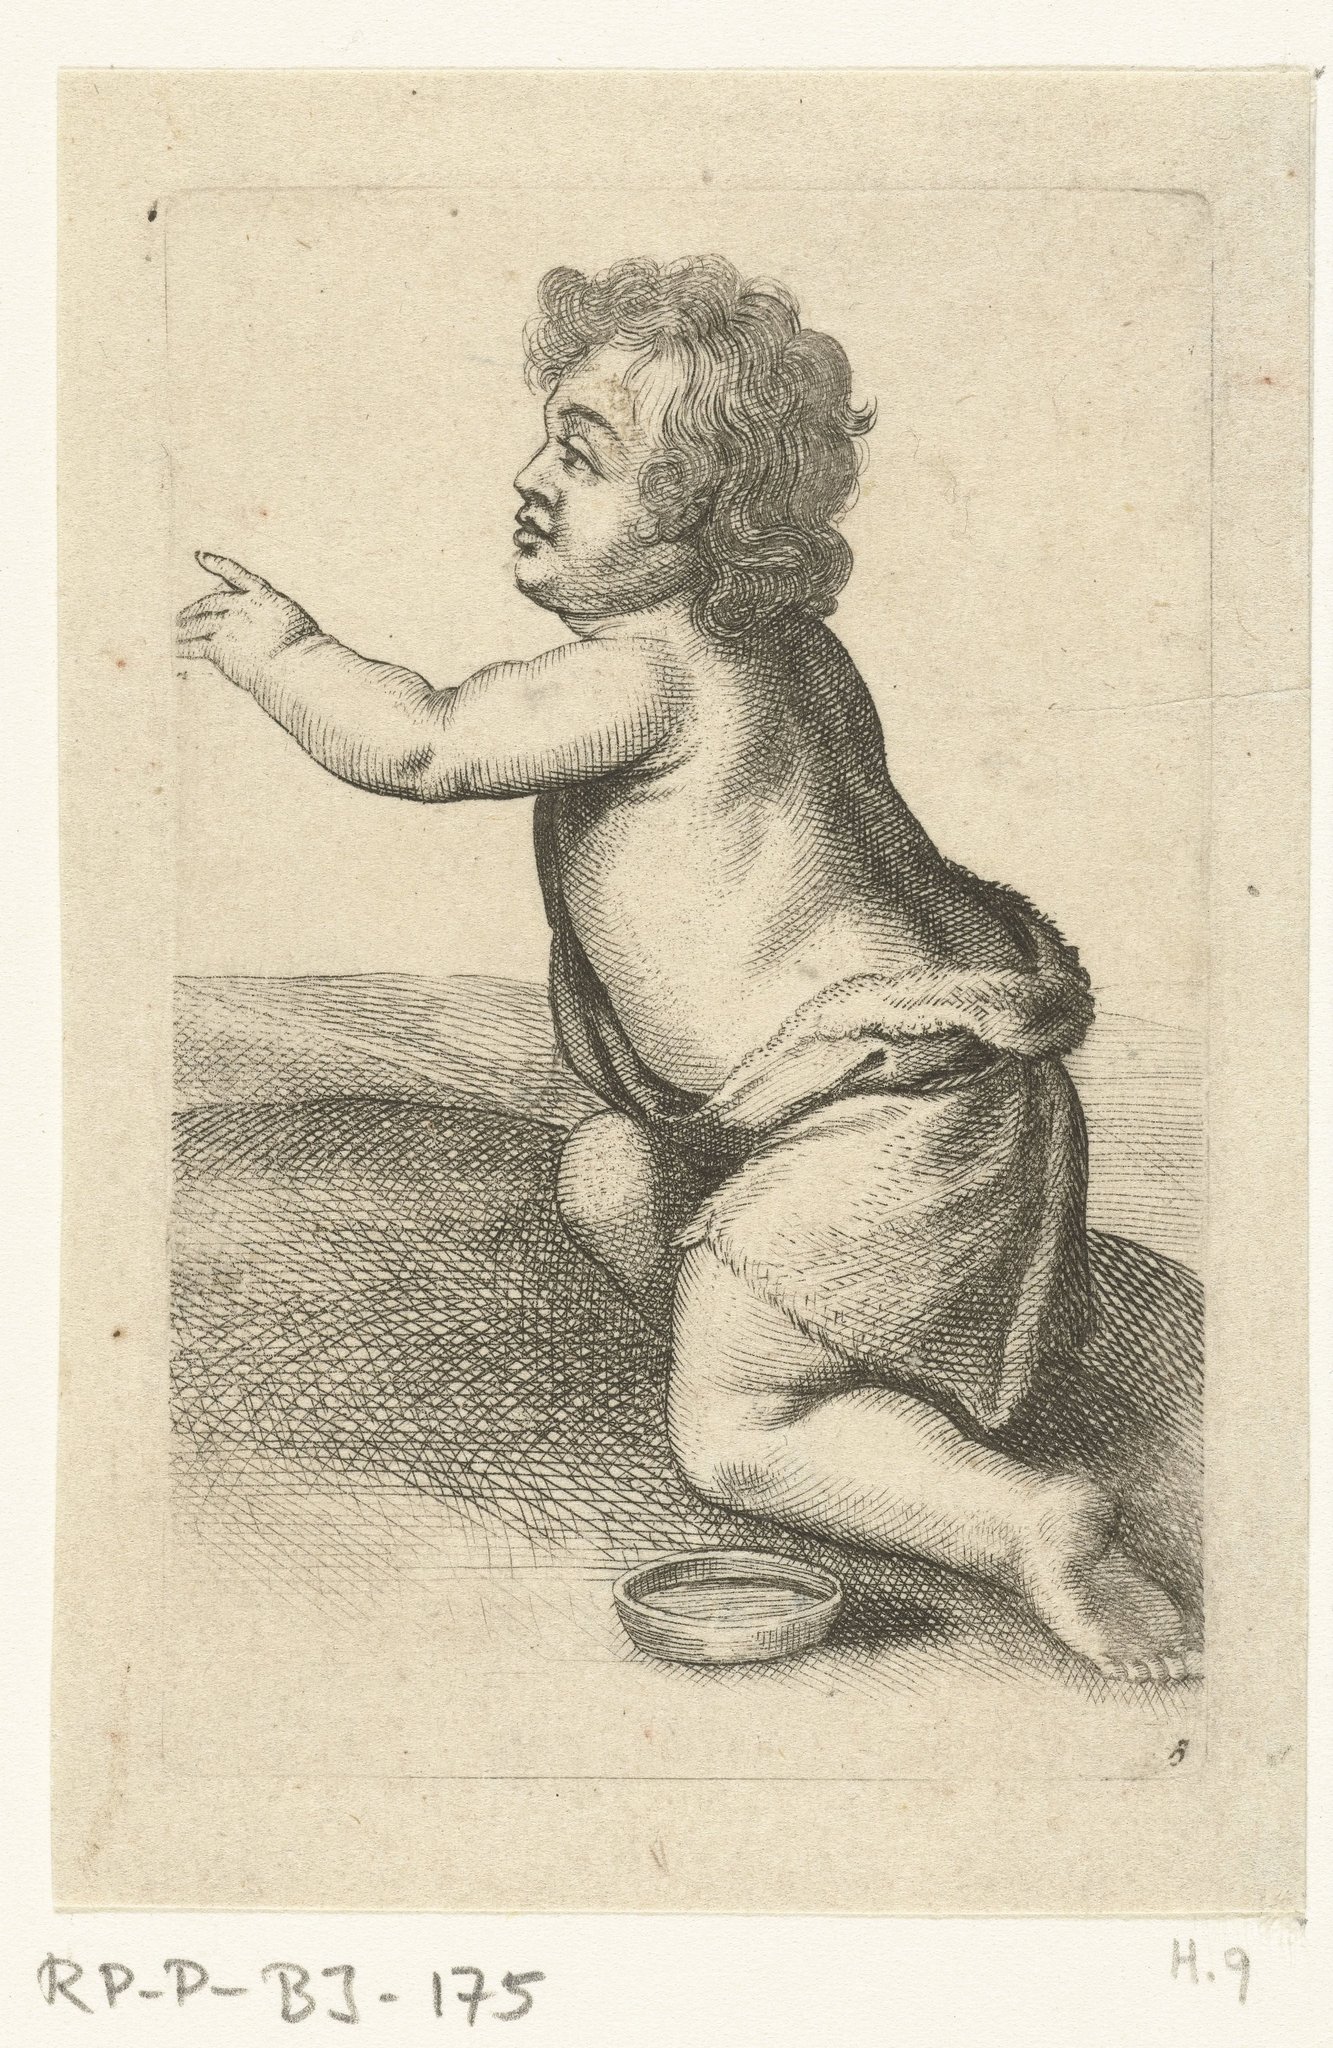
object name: print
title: Kinderen en engelen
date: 1630-1652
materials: paper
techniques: engraving, etching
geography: amsterdam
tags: child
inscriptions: collector's mark: Lugt 2228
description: Halfnaakt kind met een schoteltje. Prent uit een serie van 24 prenten met engelen of kinderen.